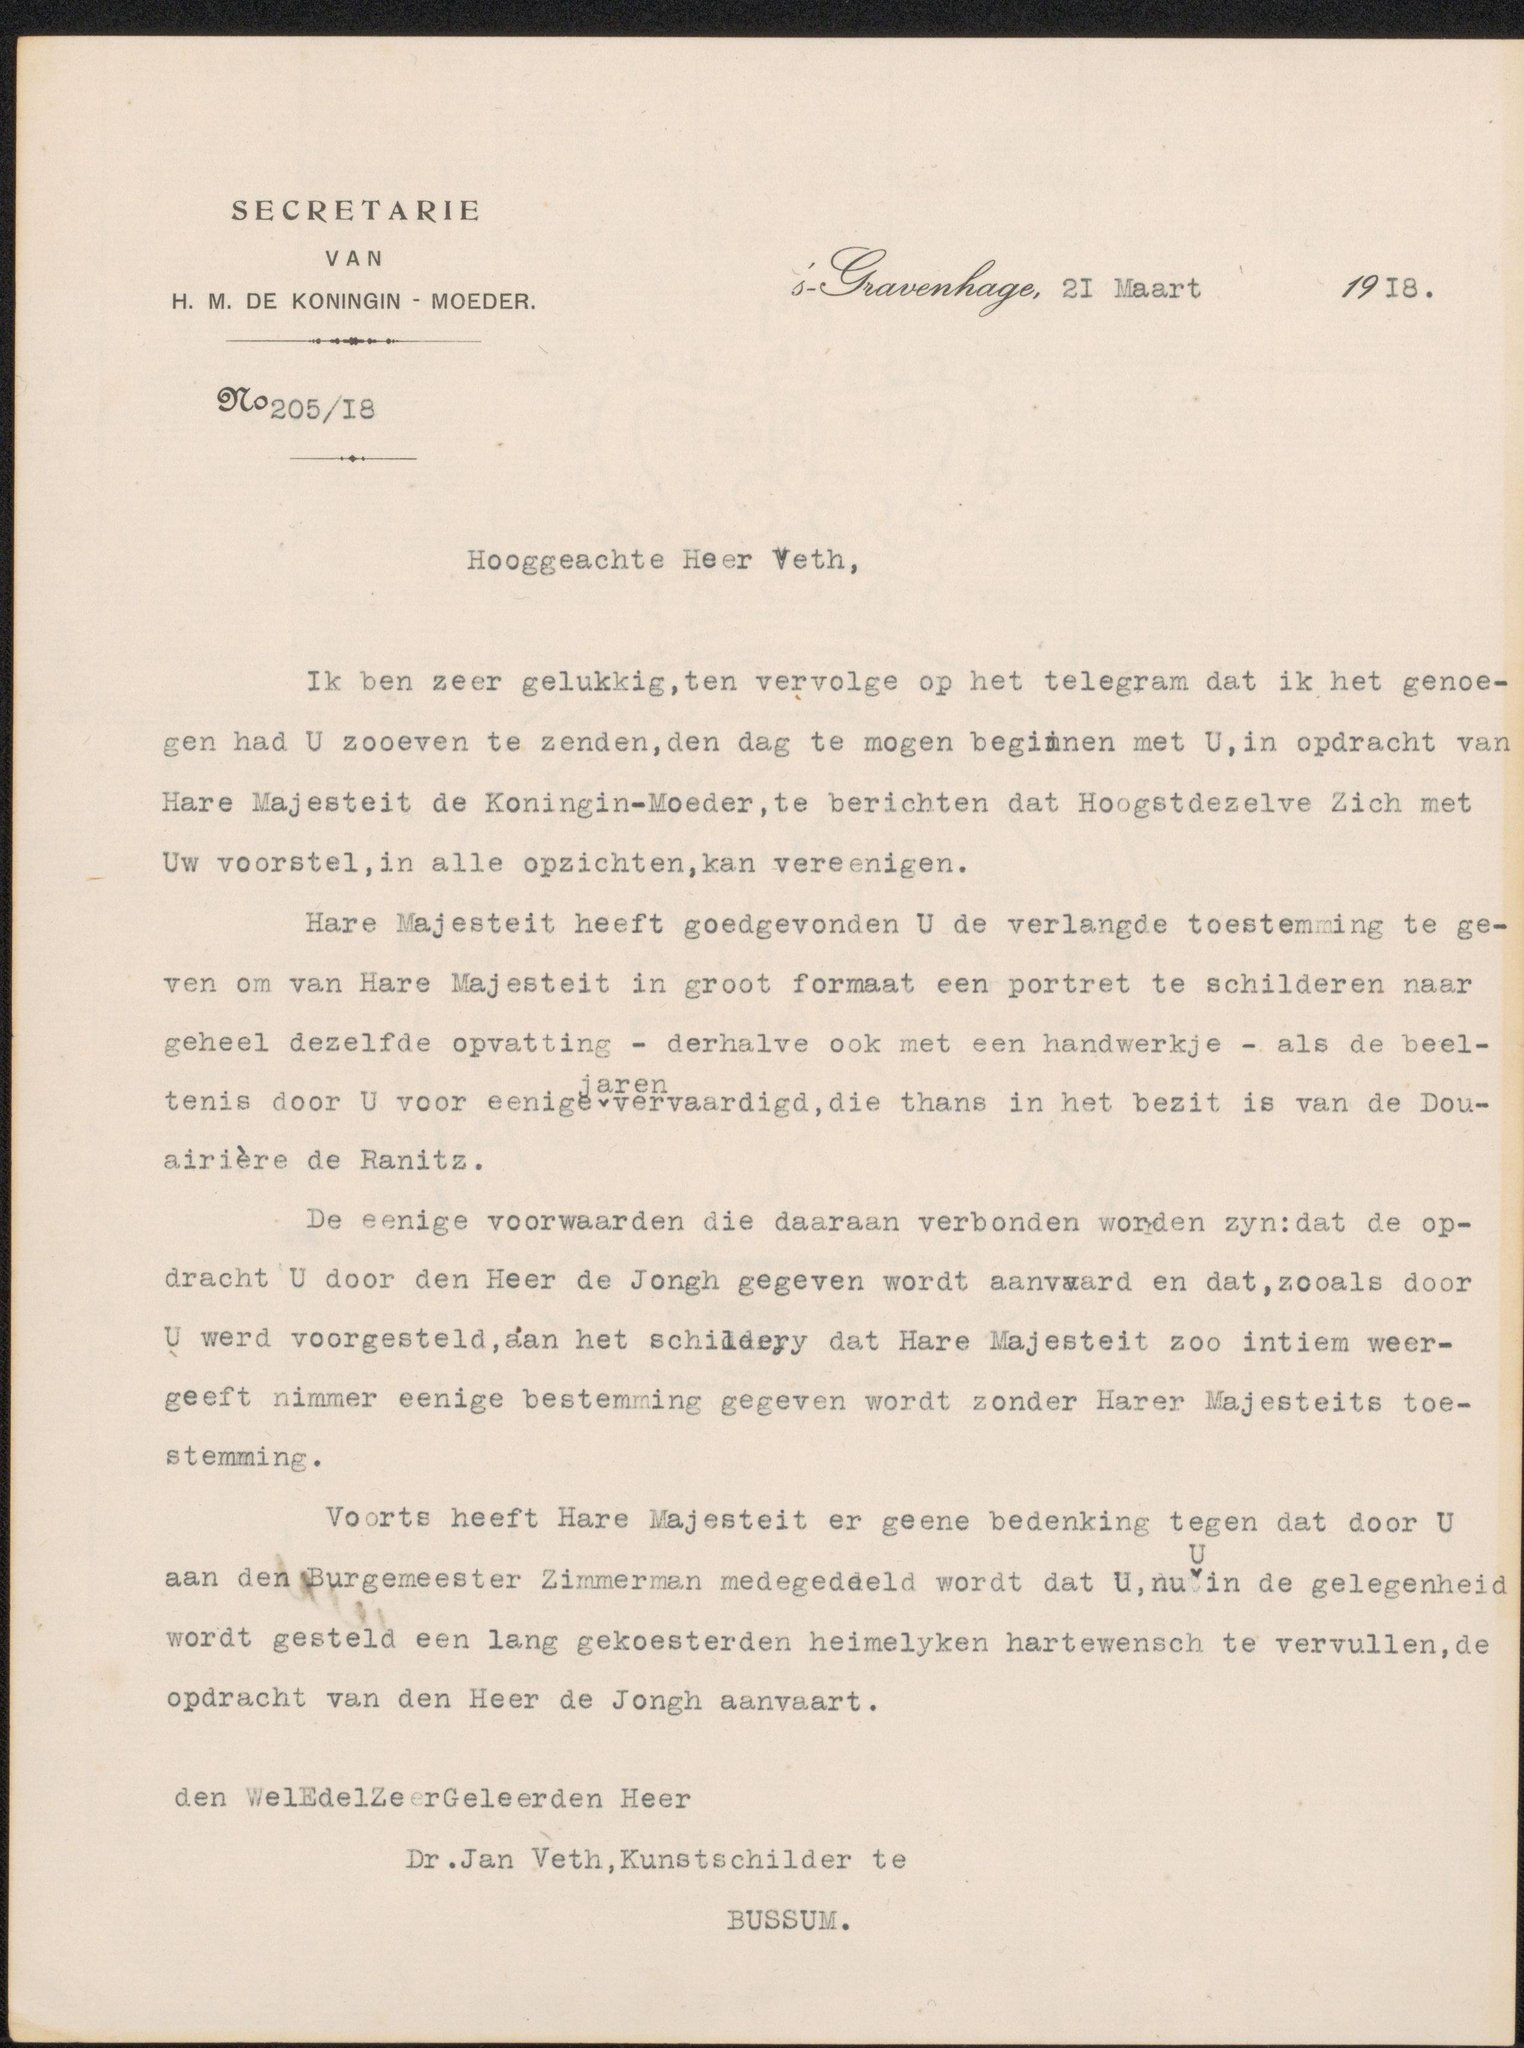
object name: letter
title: Brief aan Jan Veth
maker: Anonymous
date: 1918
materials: ink, paper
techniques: pen, printing, writing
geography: the hague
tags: mayor, alfred rudolph zimmerman, the hague, print maker, wilhelmina of the netherlands, dordrecht, amsterdam, painter, draughtsman, designer, jan veth, willem iii (koning der nederlanden), historical persons (portraits and scenes from the life)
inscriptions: collector's mark: ‘RPK’, watermark